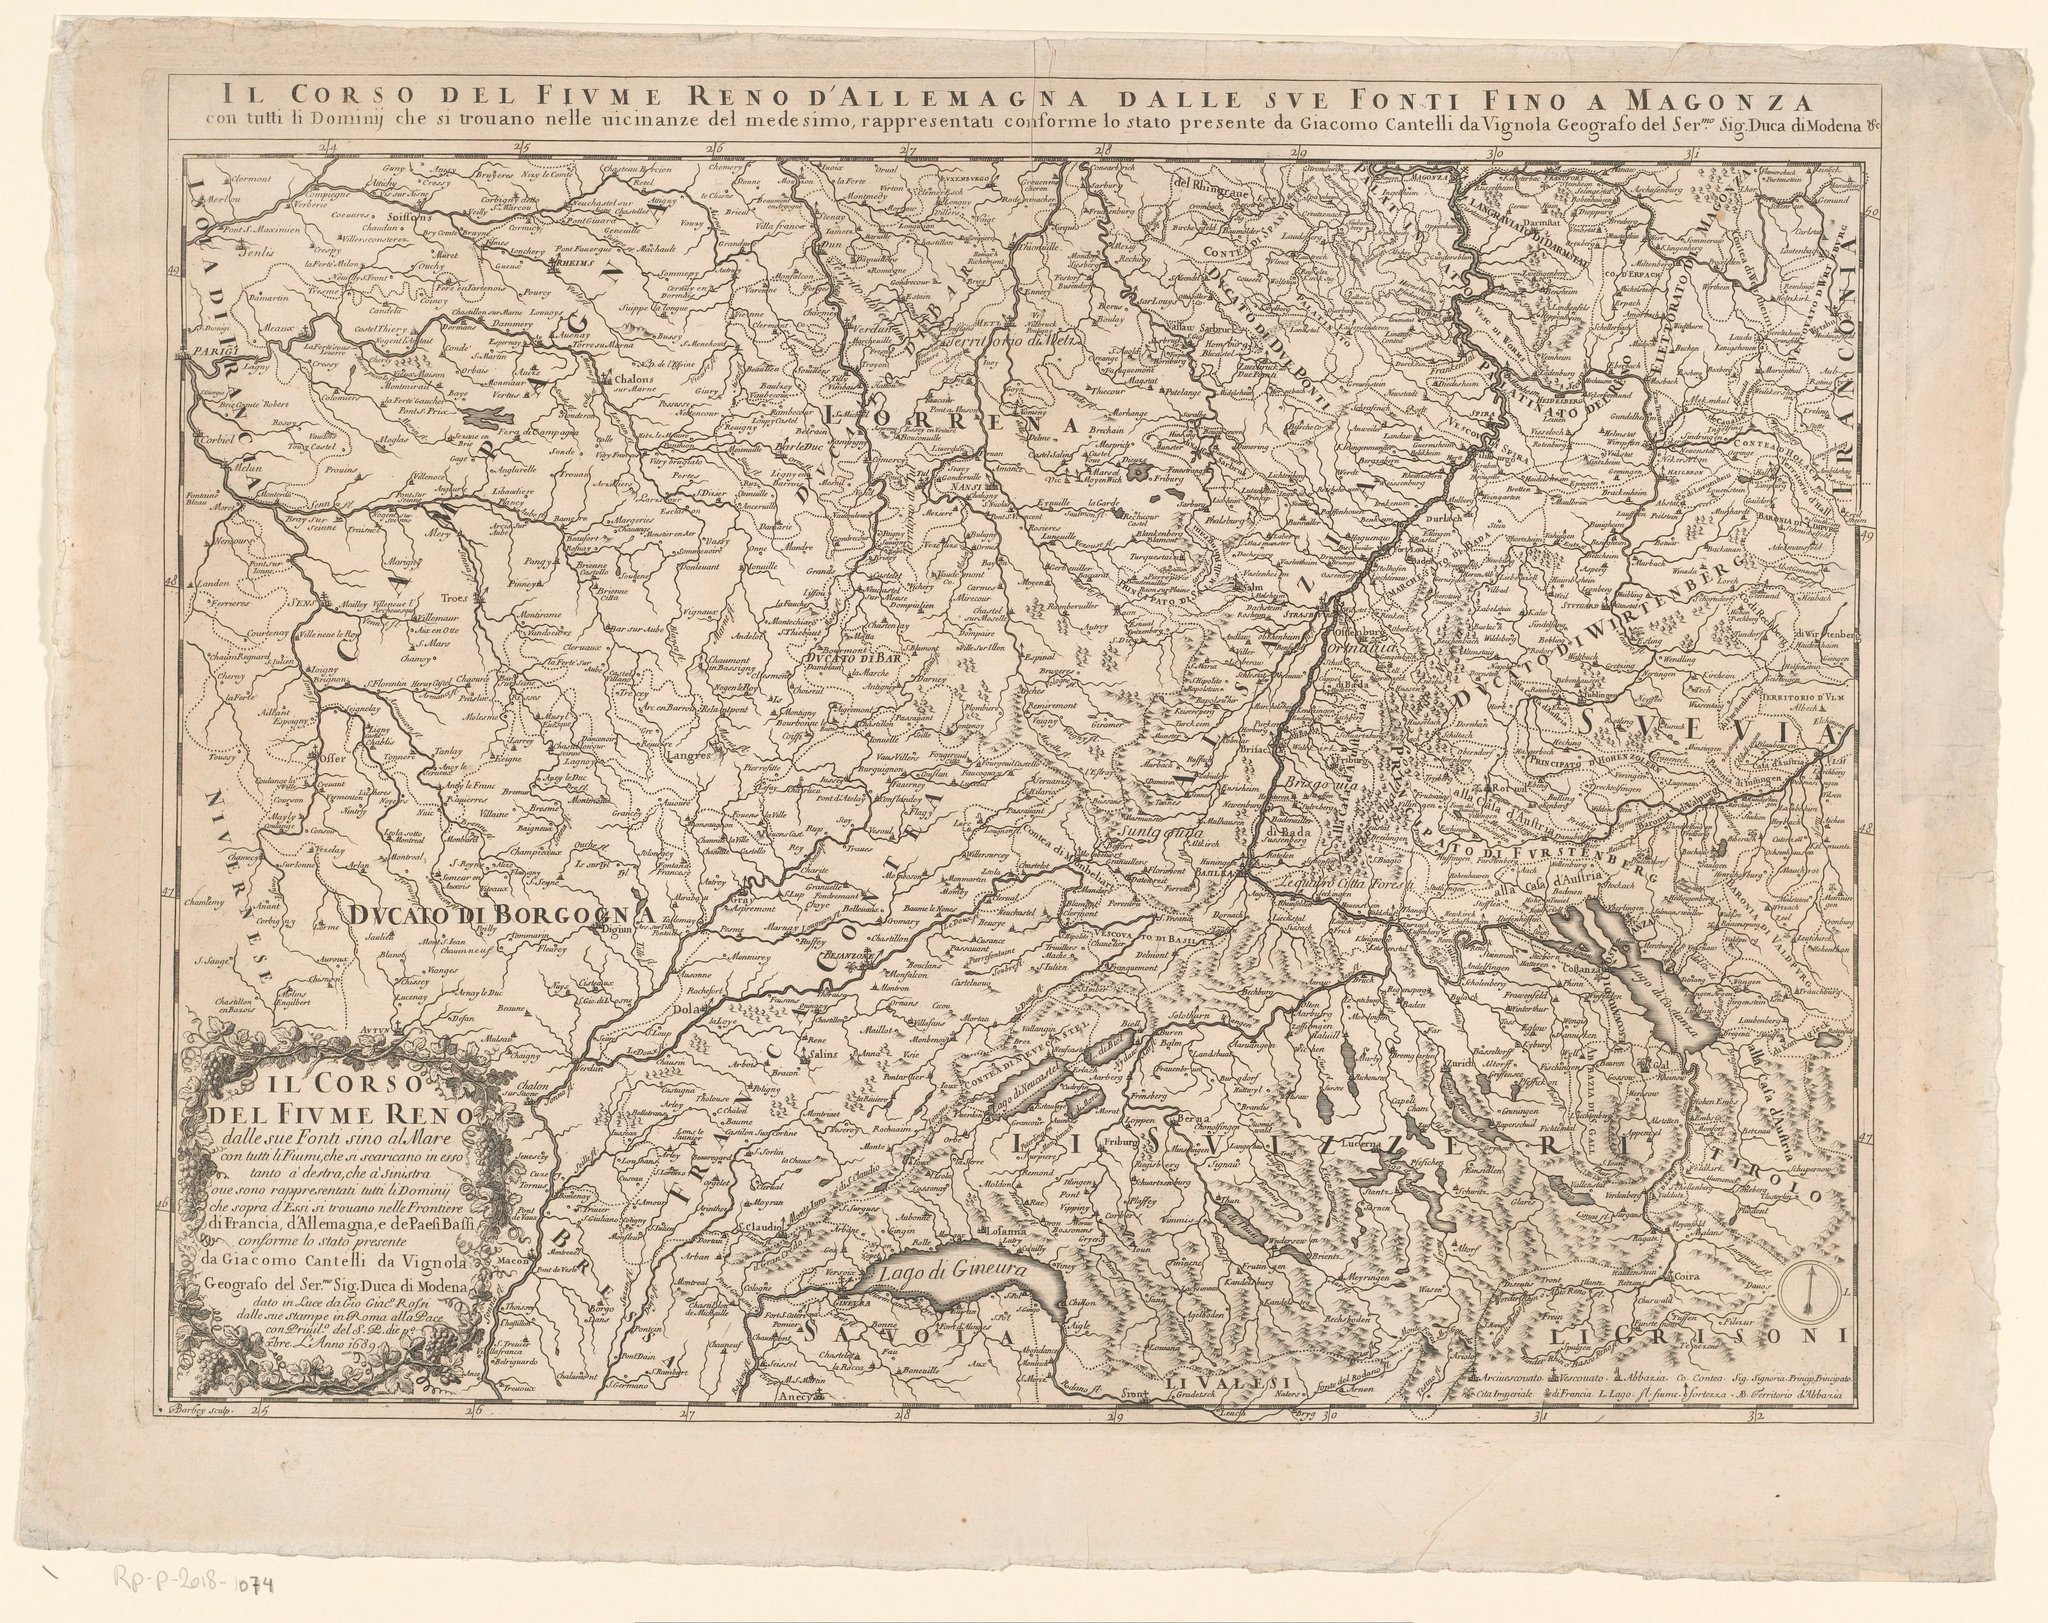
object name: print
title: Kaart van het Rijngebied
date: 1689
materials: paper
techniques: engraving, etching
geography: modena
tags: maps of separate countries or regions, river, germany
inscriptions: collector's mark: Lugt 2228